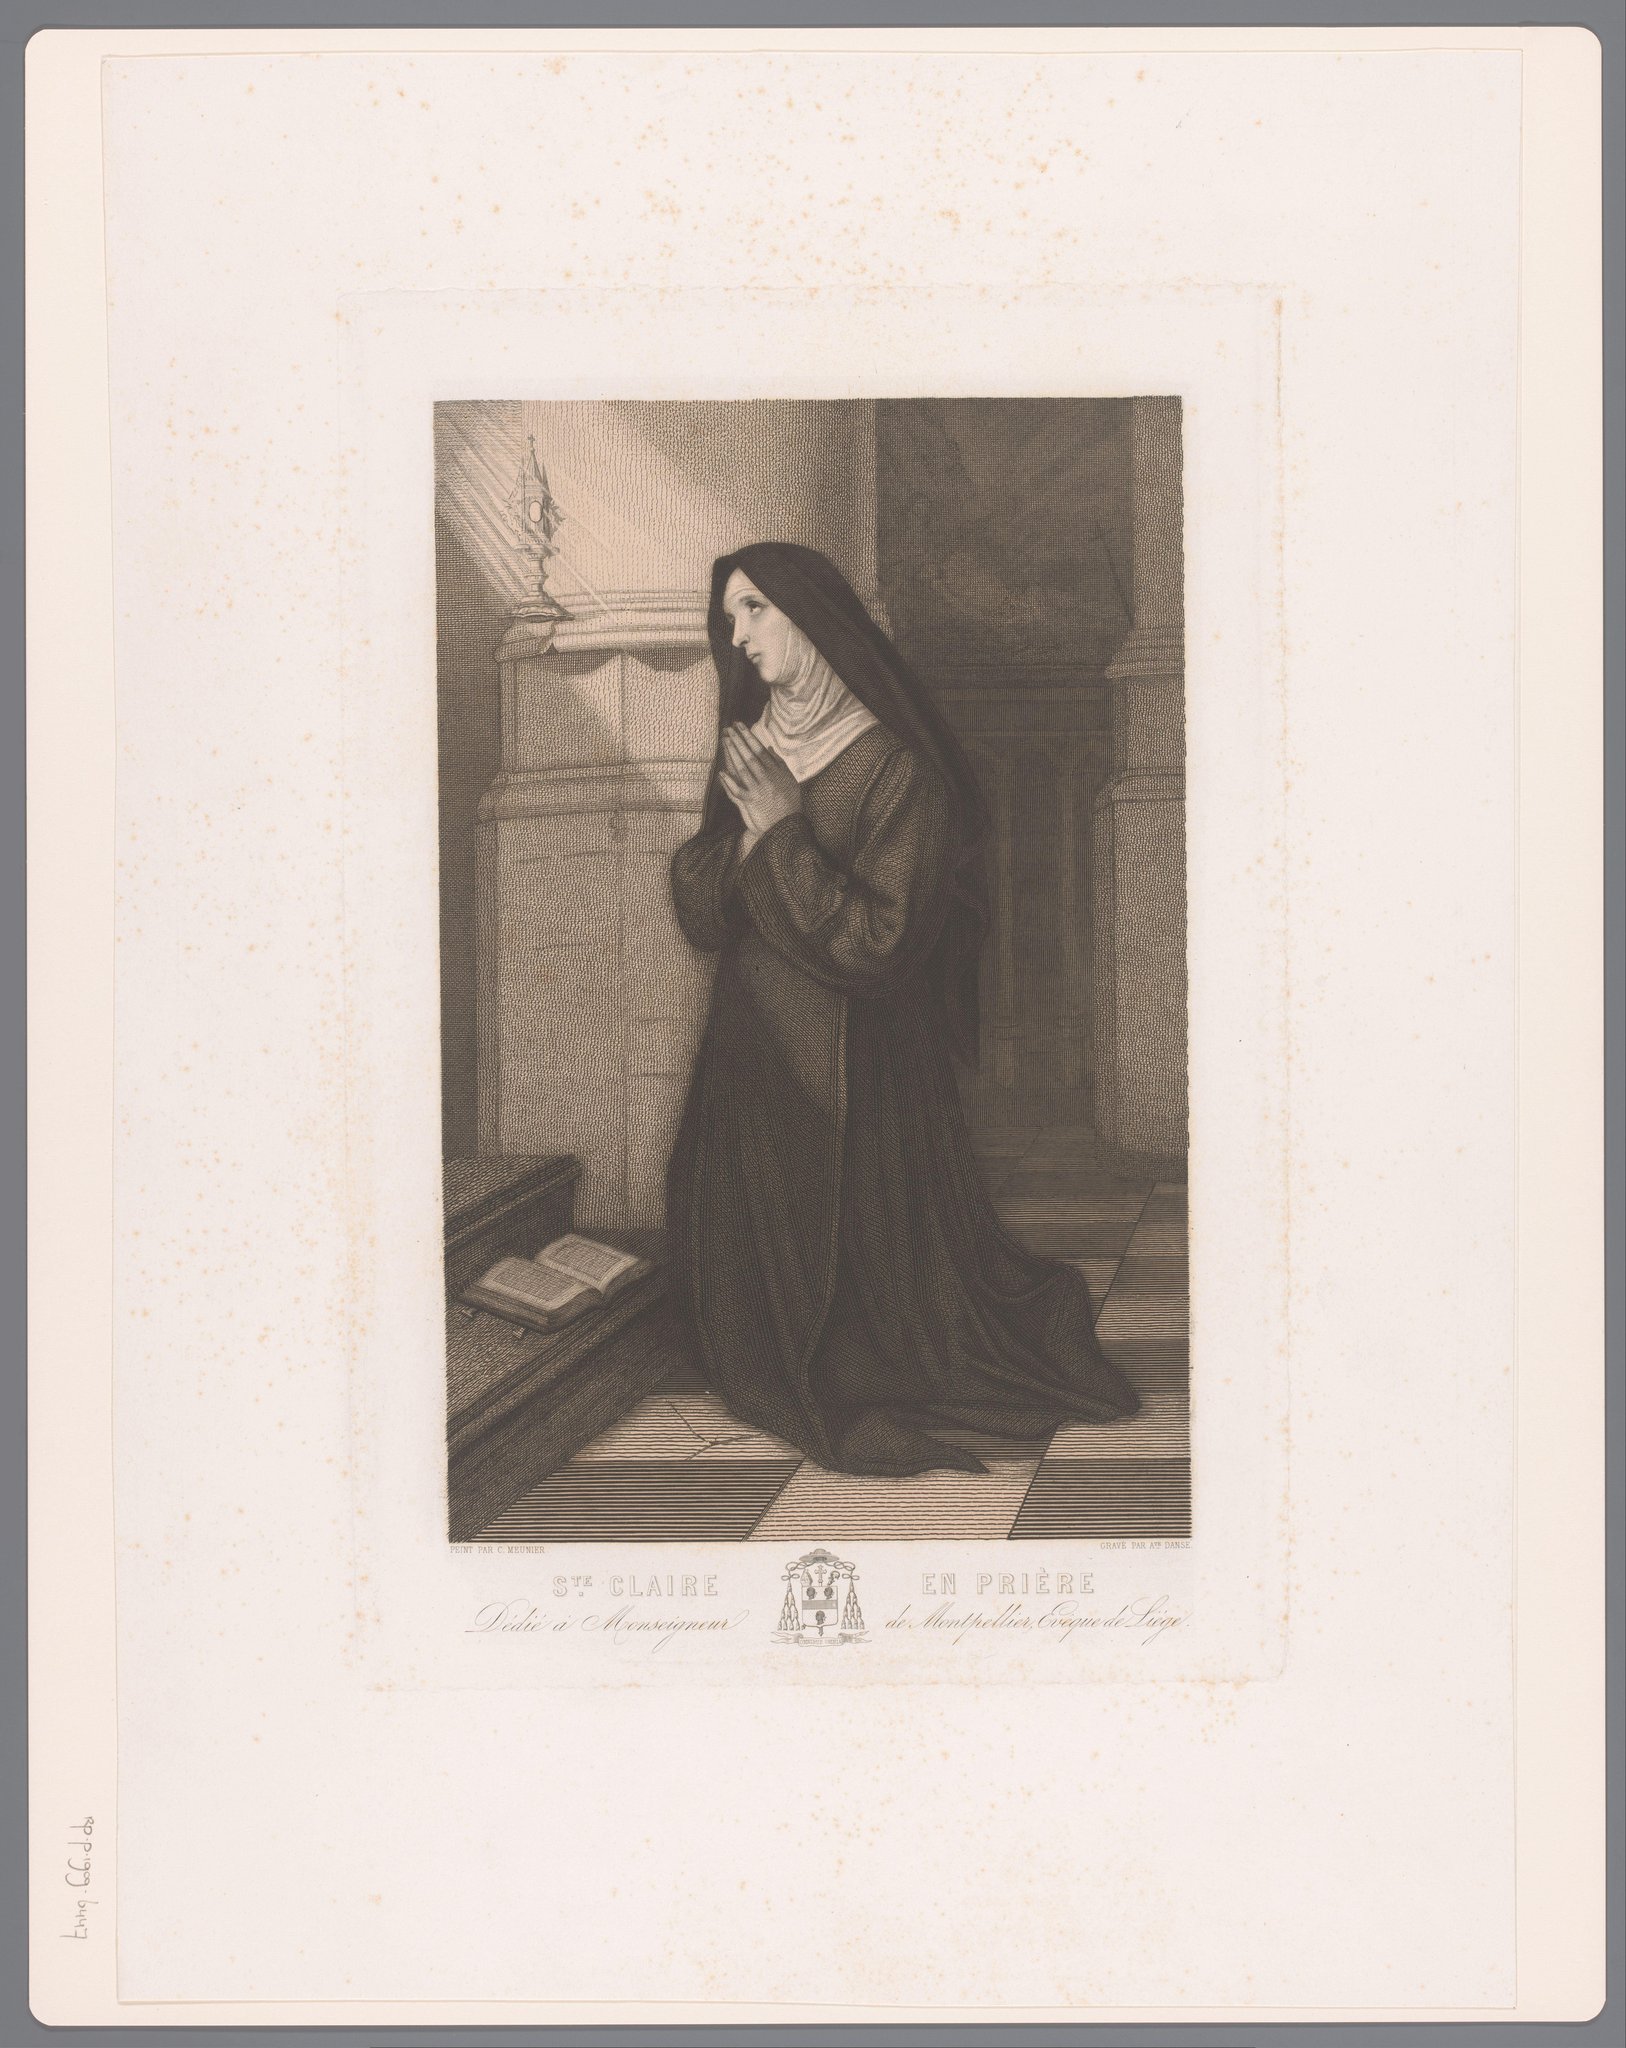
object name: print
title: Clara van Assisi, geknield in gebed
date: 1863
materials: paper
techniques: engraving, etching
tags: clergyman, the virgin and foundress of the order of minoresses (or poor clares), clare of assisi; possible attributes: book, cross, flaming horn, lily, monstrance, palm-branch, pastoral staff, rosary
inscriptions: collector's mark: Lugt 2228